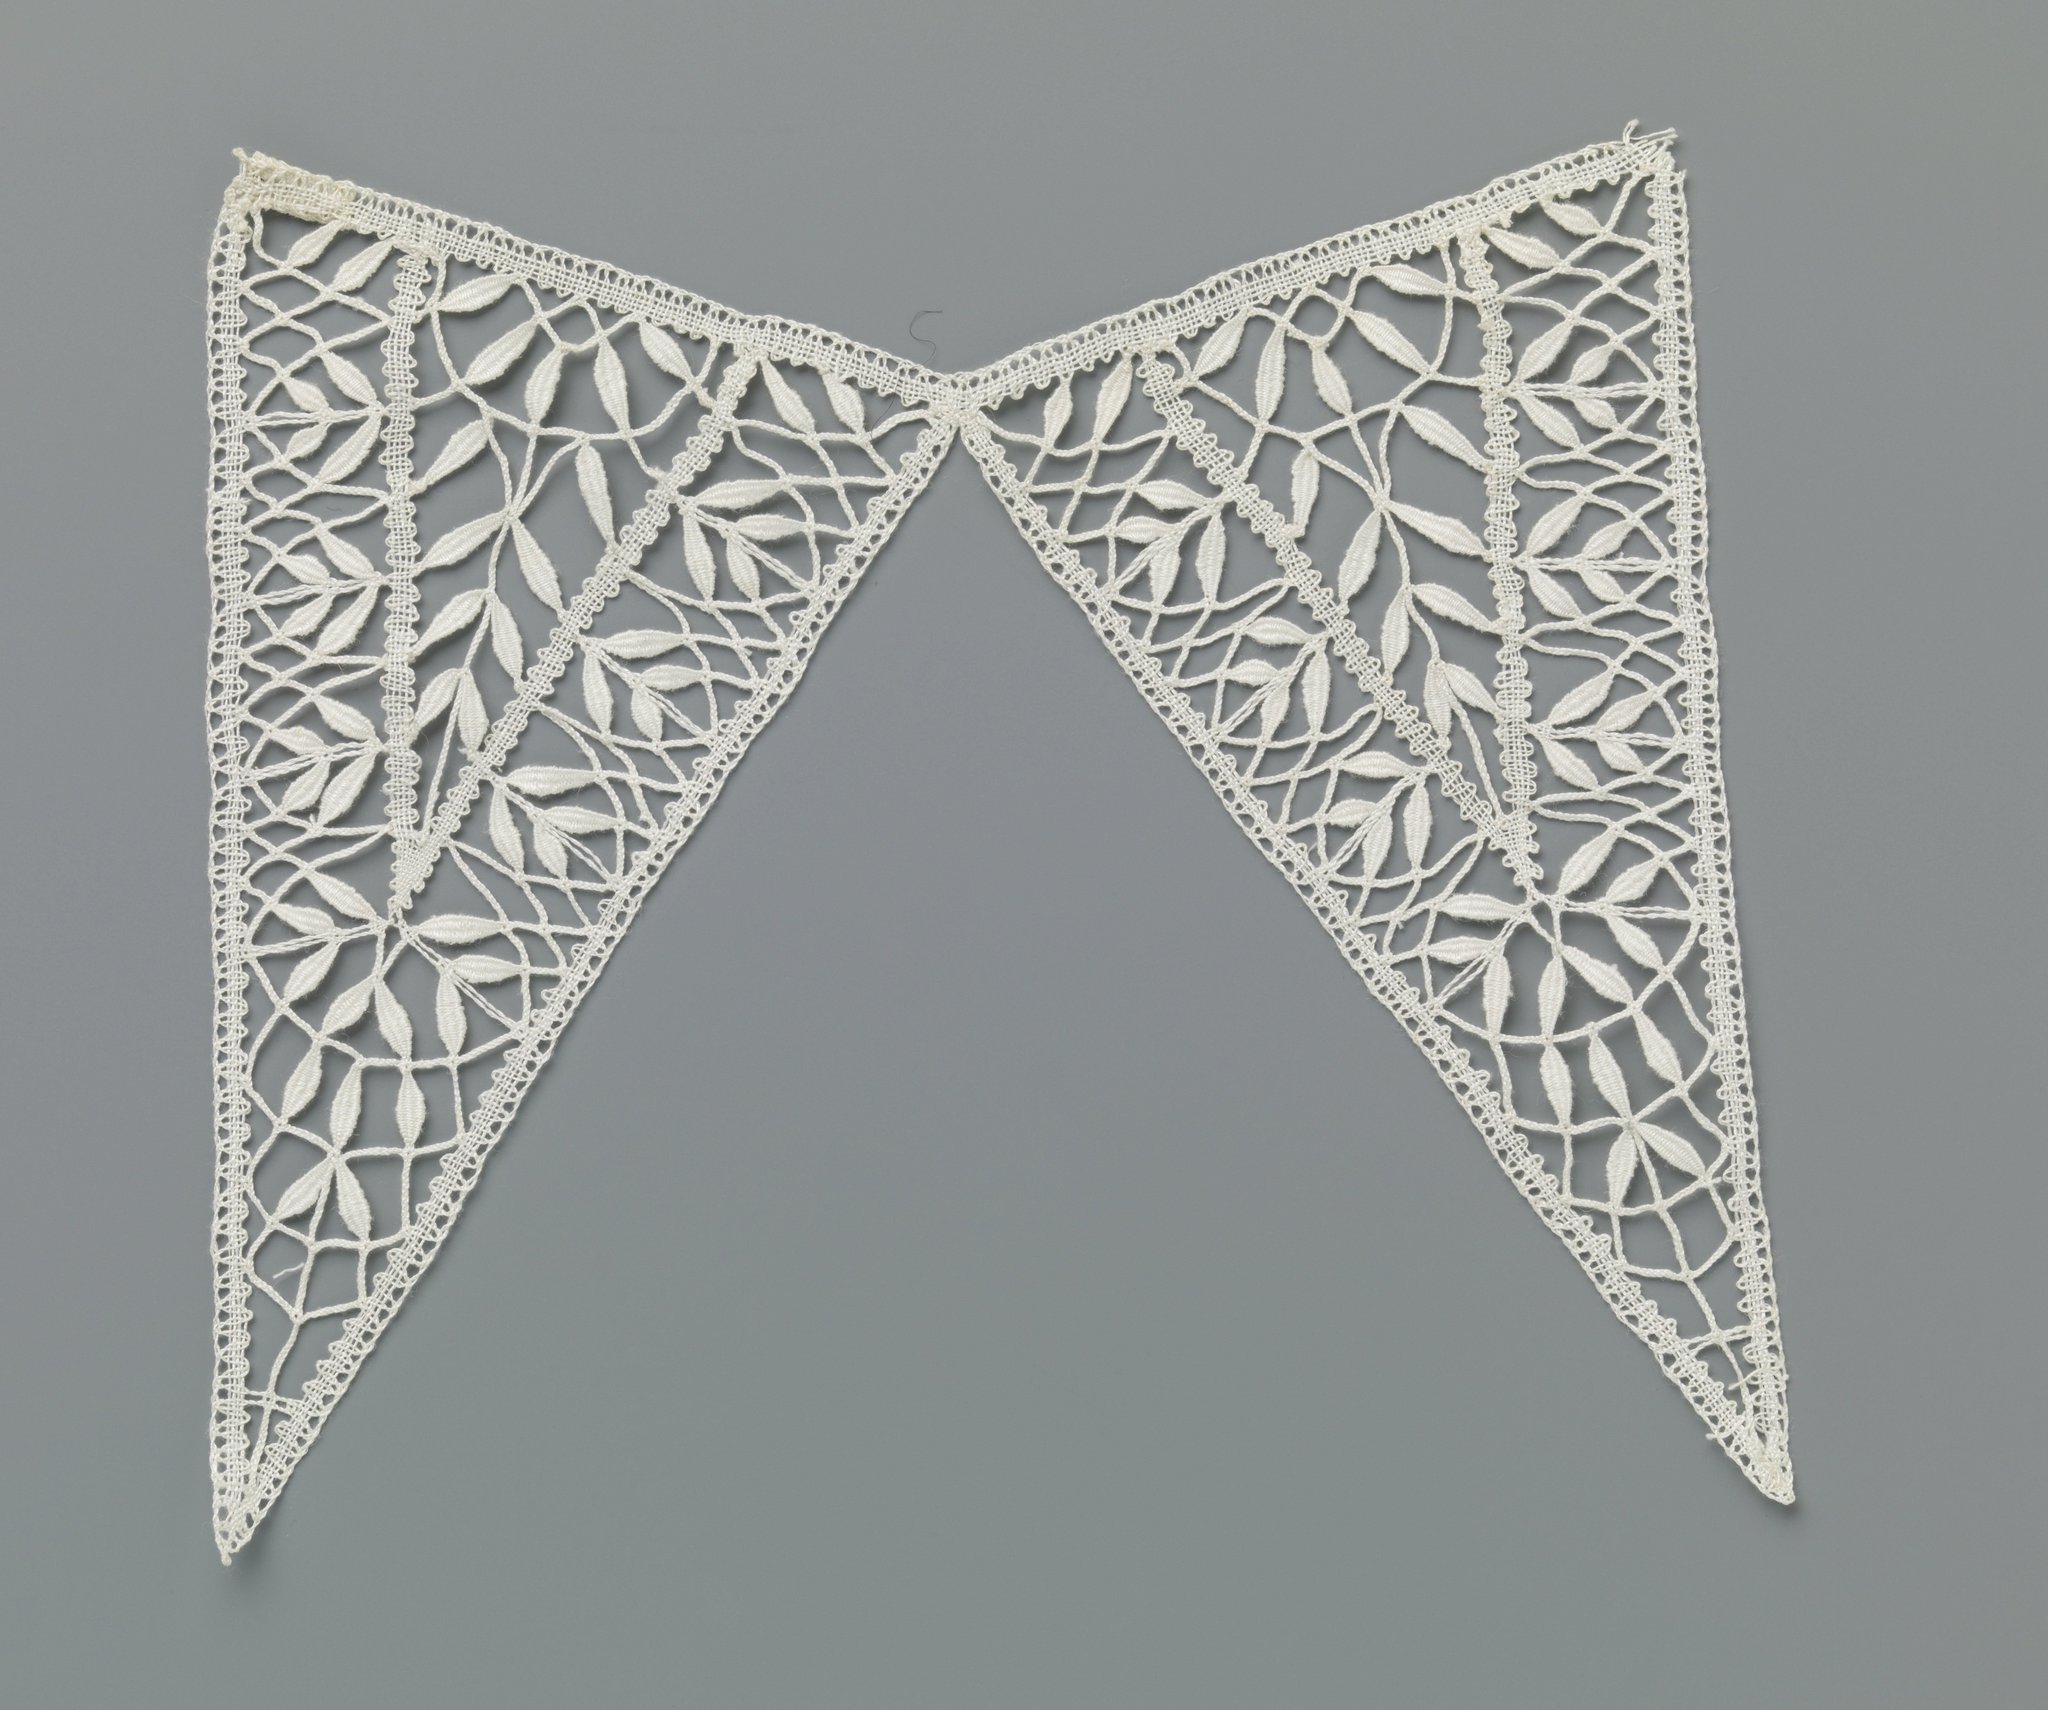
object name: fragment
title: Twee puntschulpen van kloskant met spitse blaadjes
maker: Anonymous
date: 1925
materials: linen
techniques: lace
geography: netherlands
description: Twee puntschulpen van naturelkleurige kloskant, Cluny-kant. Twee scherpe driehoekige puntschulpen zijn alleen aan de rechte bovenzijde op één punt aan elkaar verbonden. In elke driehoek hangt vanaf de bovenzijde een kleinere driehoek naar beneden. De omtrekken van de driehoeken worden gevormd door een smal bandje in linnenslag. De ruimtes in de driehoeken zijn gevuld met een vlechtengrond en spitse blaadjes gemaakt in vormslag.